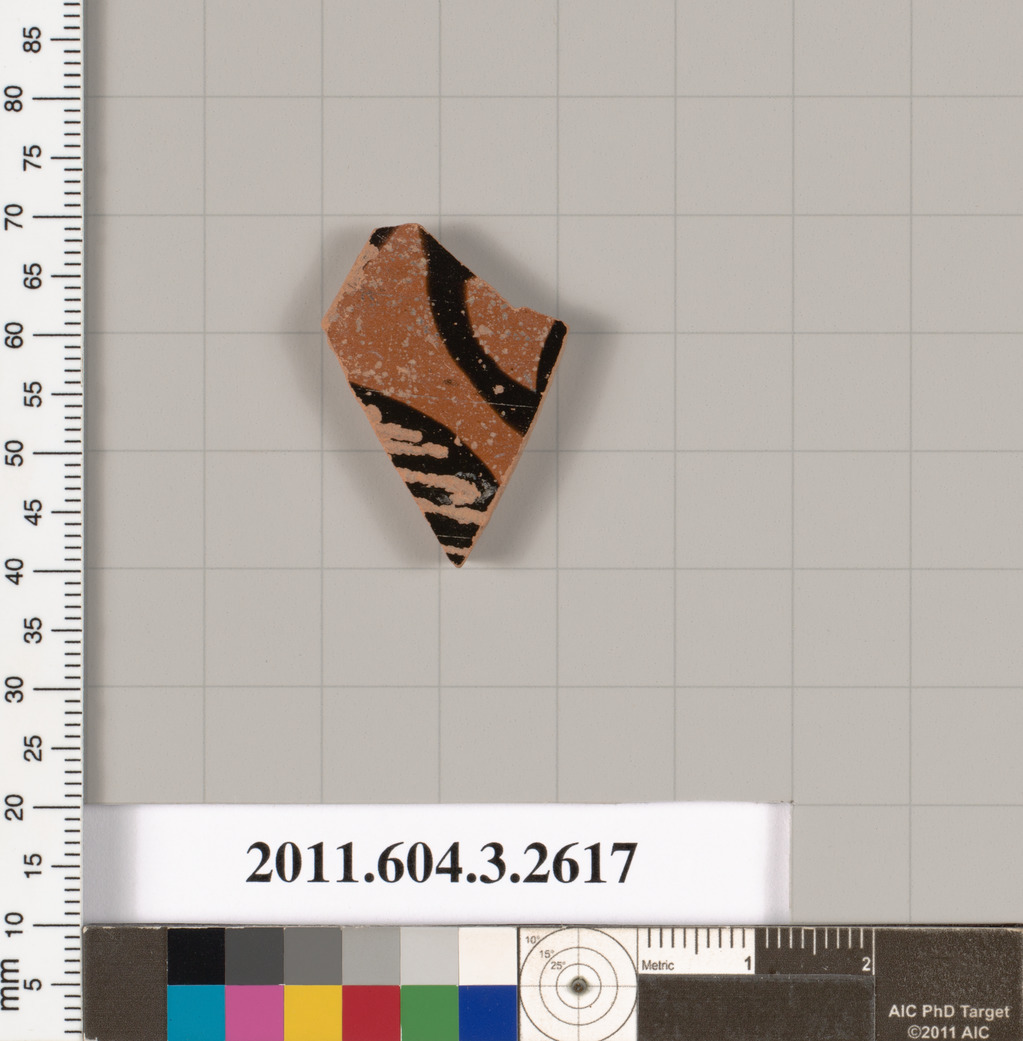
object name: kylix fragment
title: Terracotta fragment of a kylix (drinking cup)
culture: greek, attic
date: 550-501 BCE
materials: terracotta